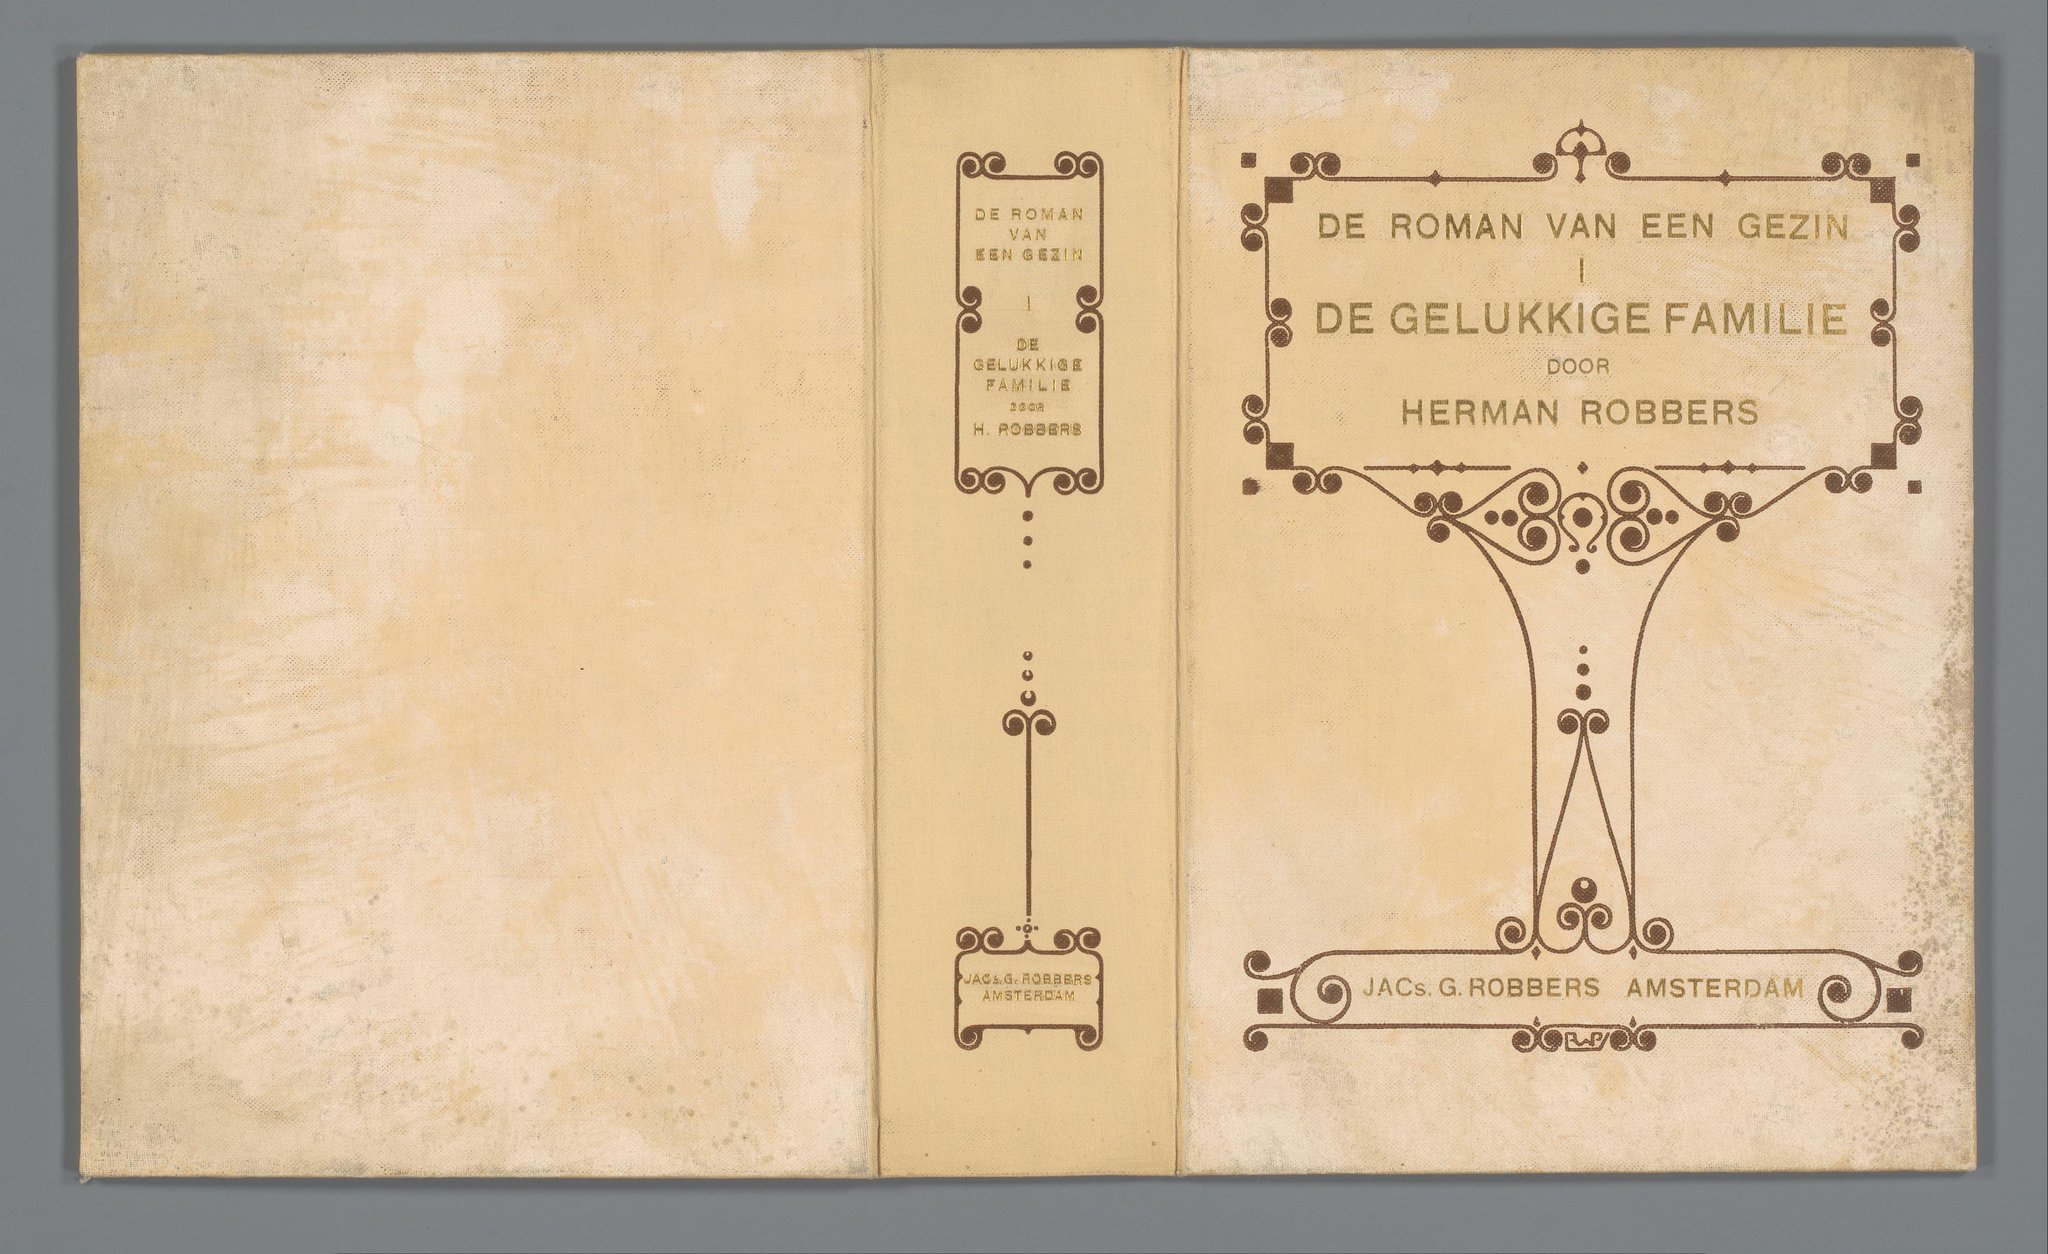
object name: binding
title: Boekband voor: Herman Robbers, De roman van een gezin I. De gelukkige familie, 1909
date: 1909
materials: cardboard, linen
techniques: printing block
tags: ornaments ~ art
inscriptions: collector's mark: ‘R:MVS.’